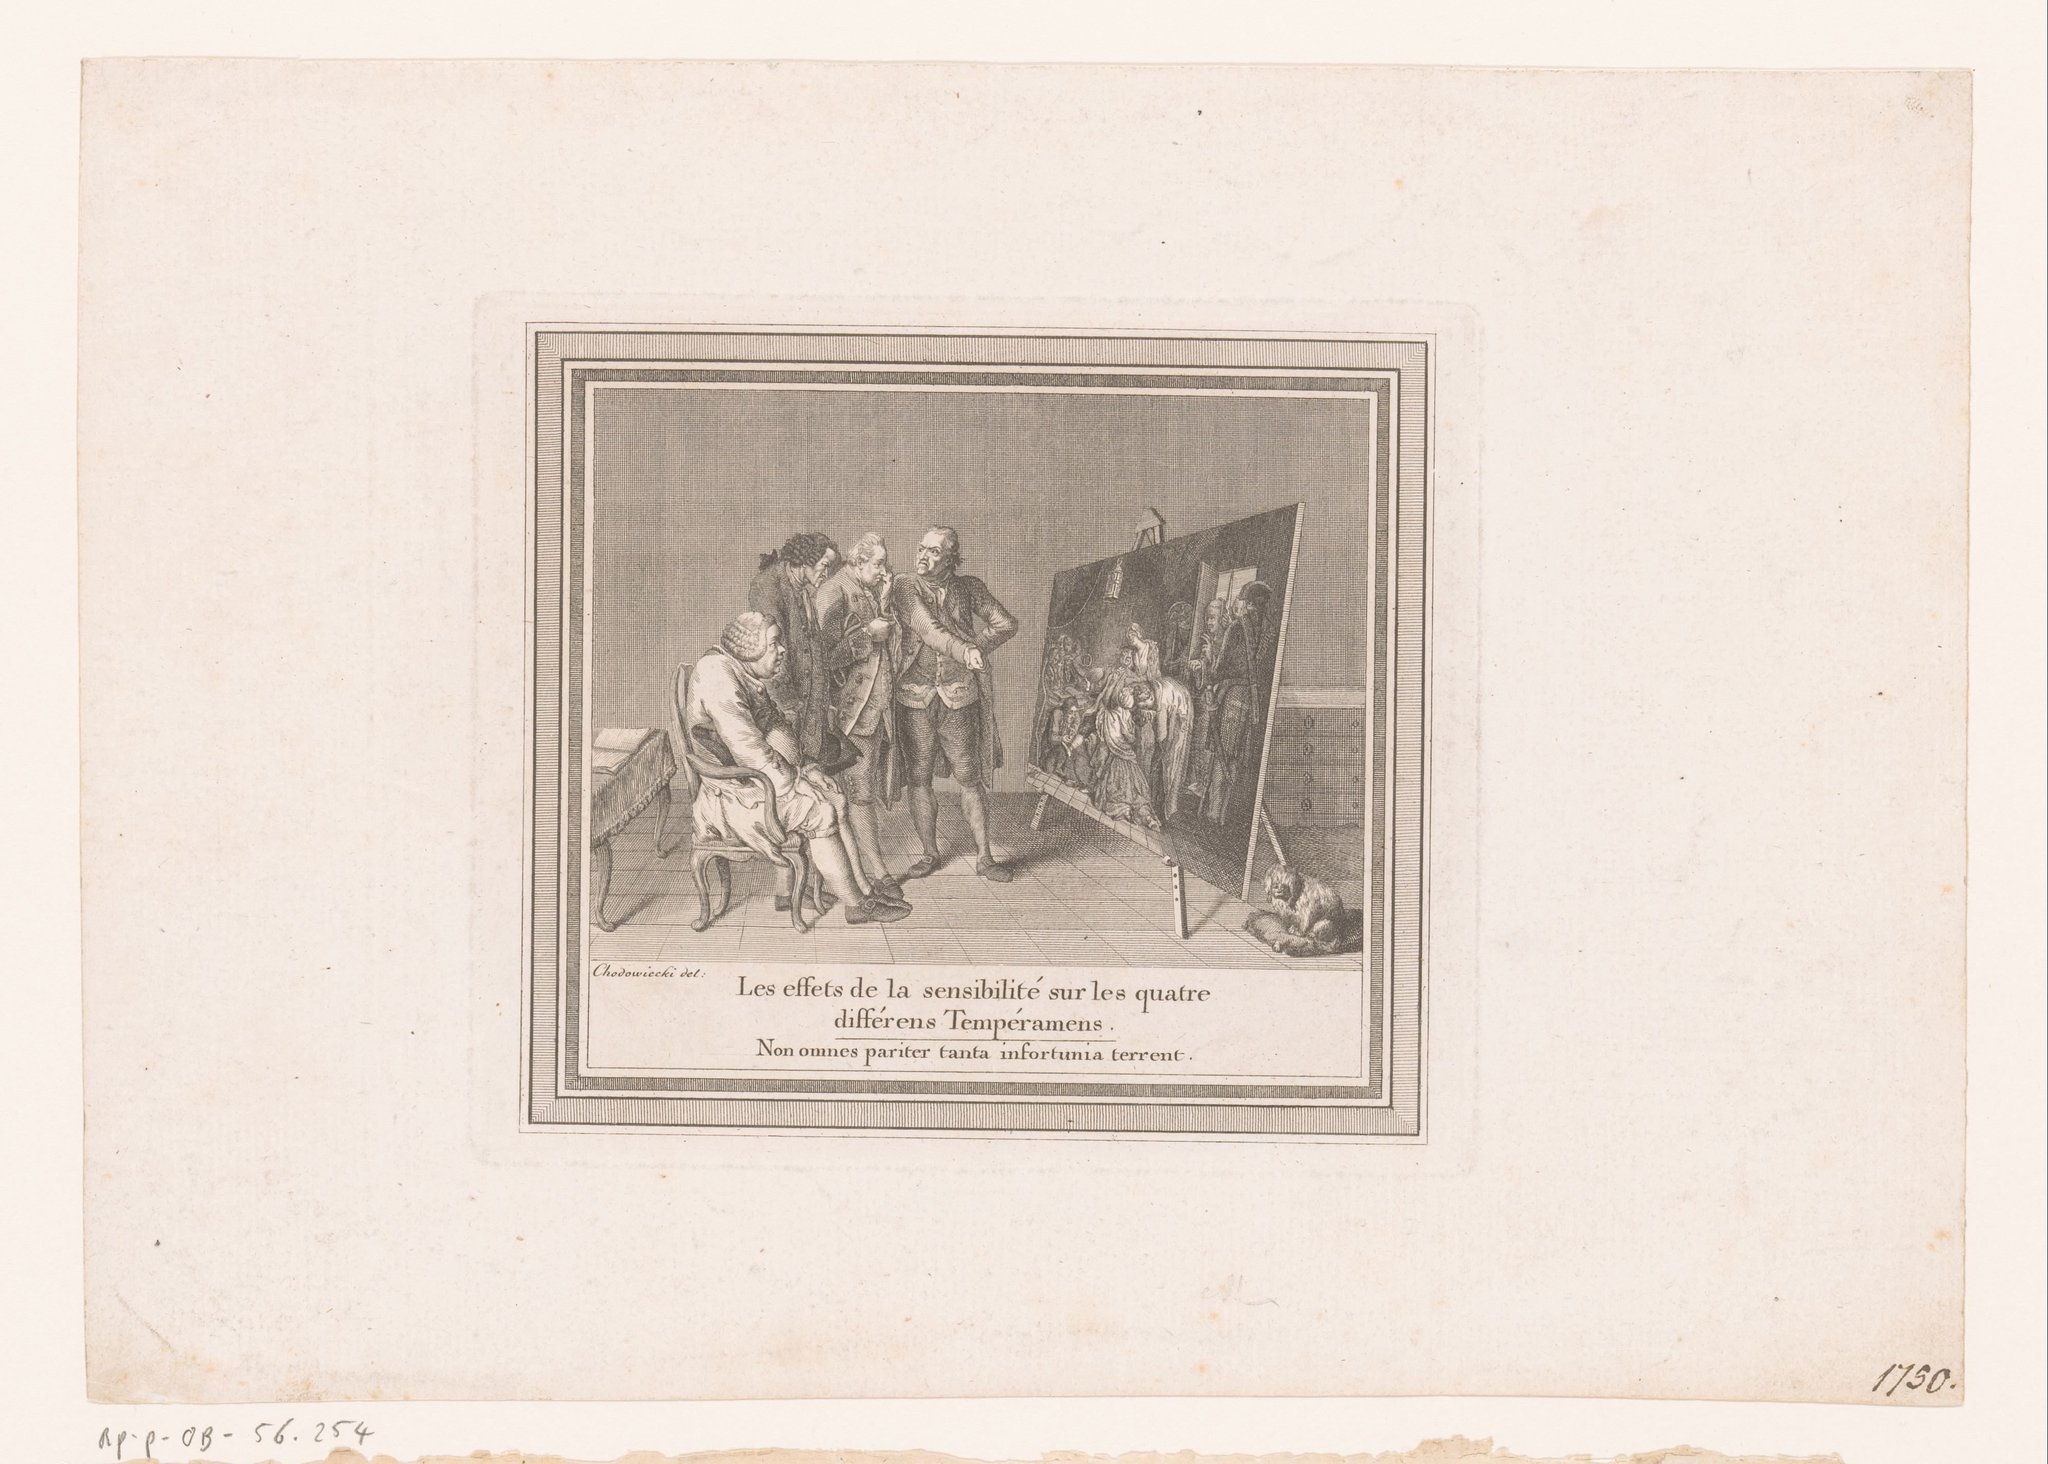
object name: print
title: Effect van gevoeligheid op de vier verschillende temperamenten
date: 1767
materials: paper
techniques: etching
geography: germany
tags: 32a1 the four temperaments; 'complessione' (ripa), parody on art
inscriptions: collector's mark: Lugt 2228